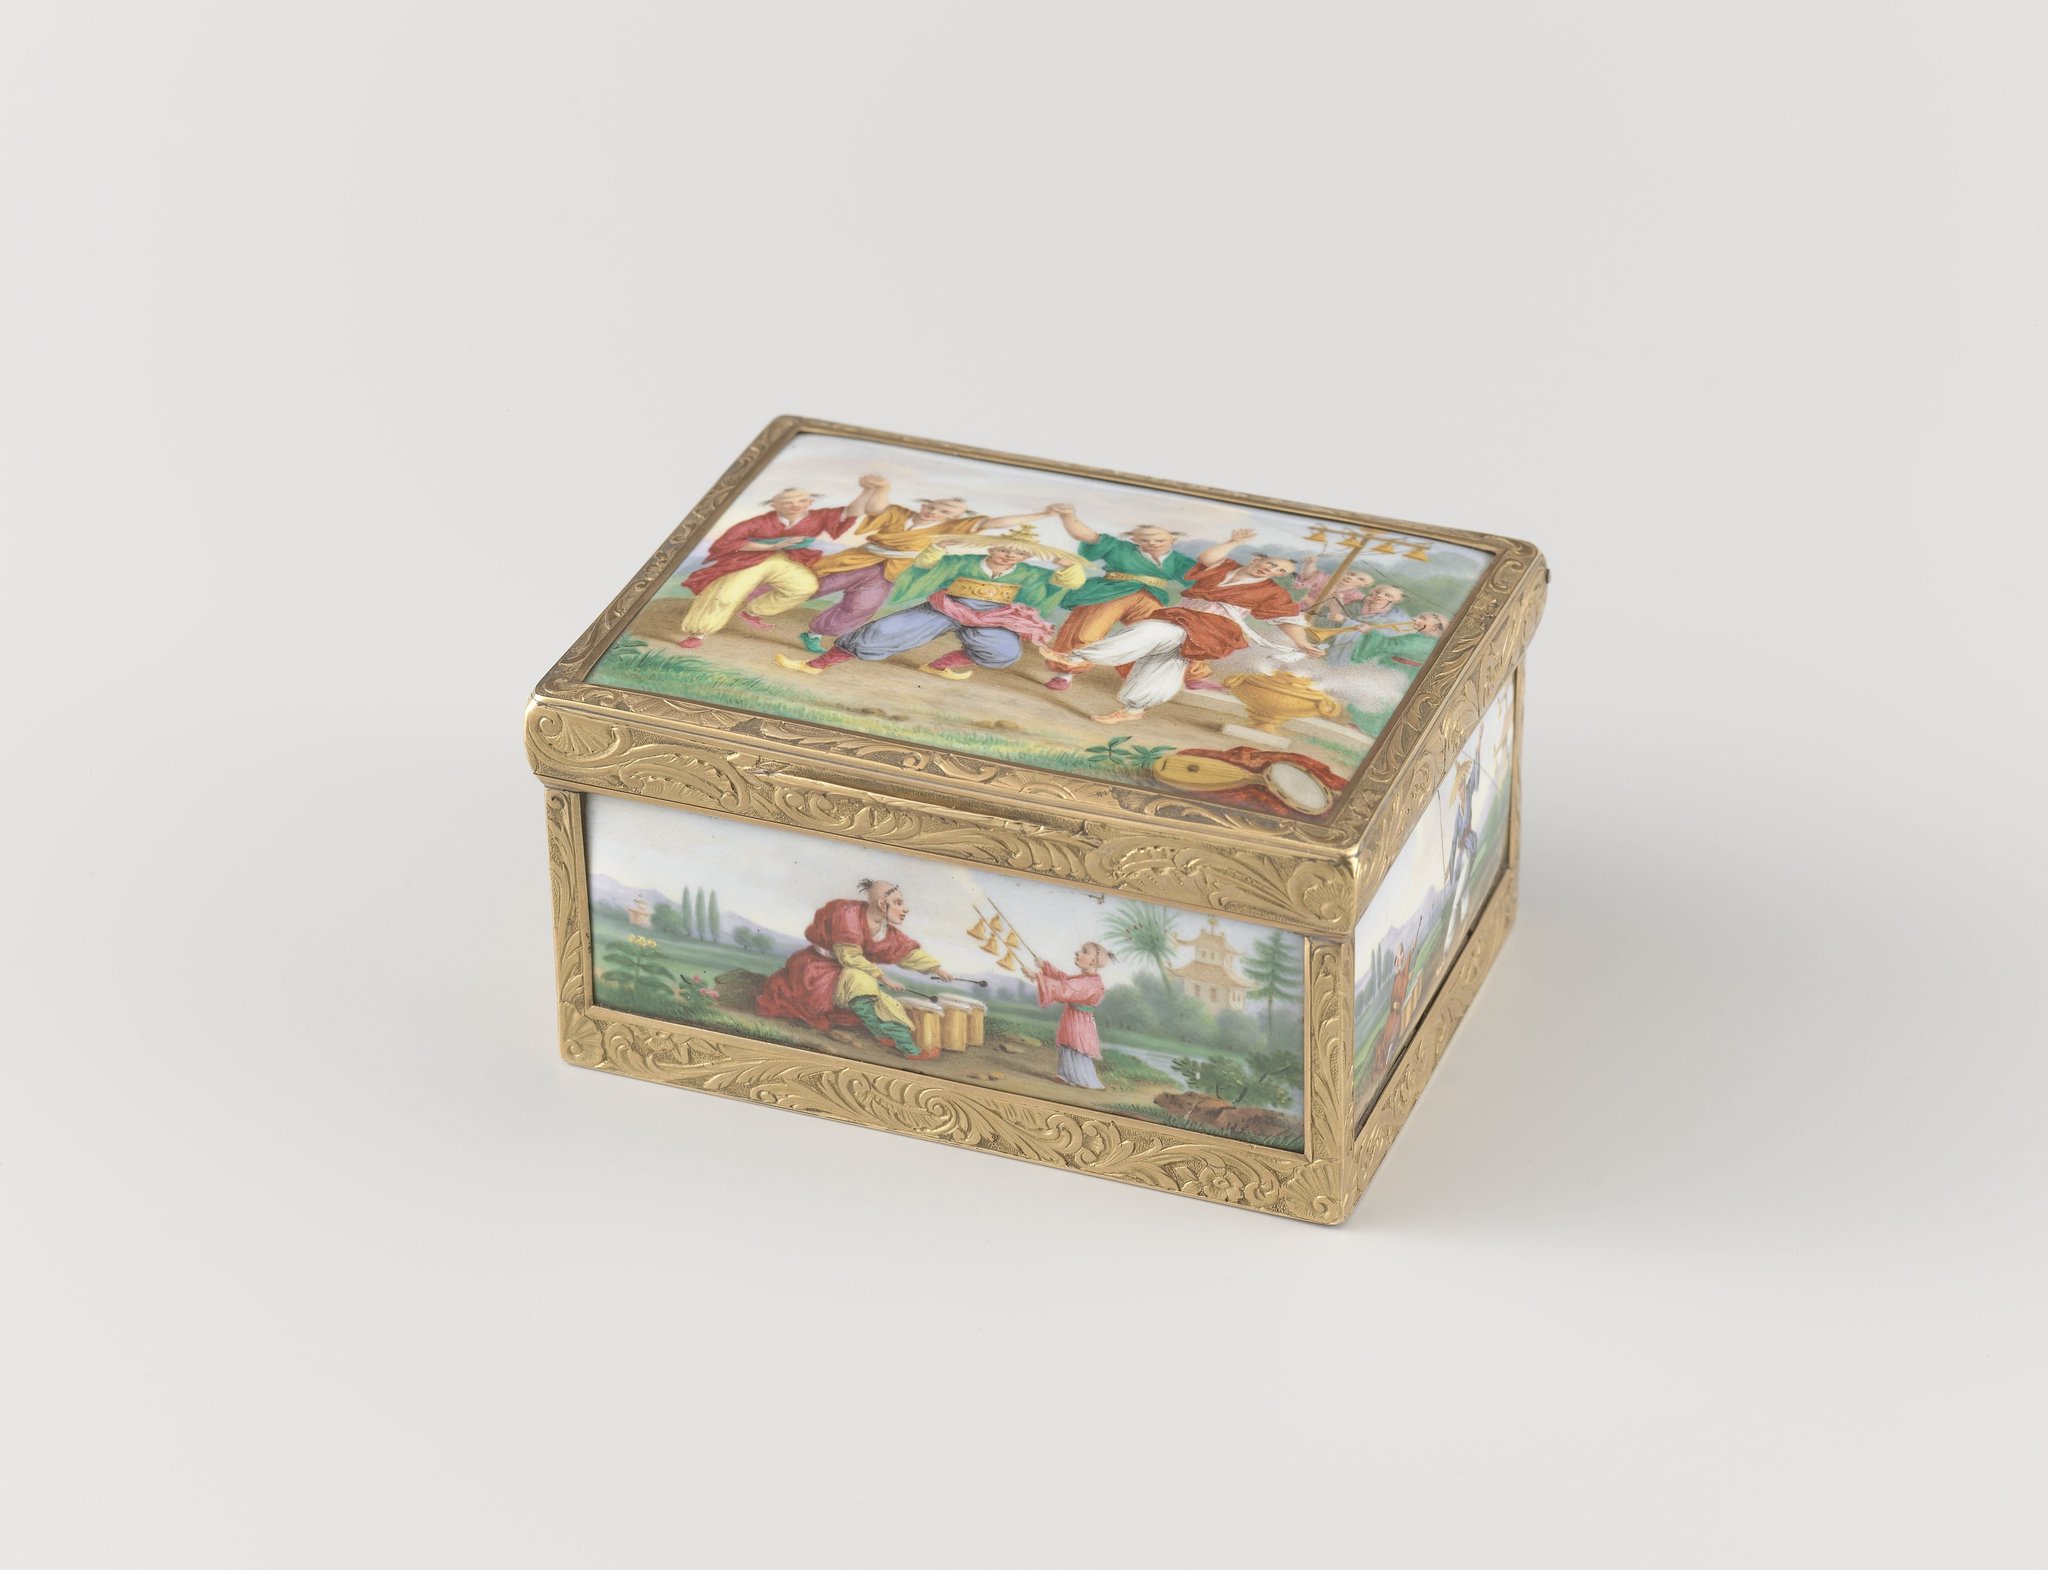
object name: snuffbox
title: Snuifdoos van goud, rechthoekig met gewelfd deksel. Geheel geëmailleerd en beschilderd met Chinoiserieën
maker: Anonymous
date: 1820-1840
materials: gold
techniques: painted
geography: paris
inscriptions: date letter (false), countermark (false), maker's mark (false), duty mark (false)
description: Snuffbox. Gold and enamel. Paris, 1753 - 1754, by Noël Hardivilliers. Snuffbox. Gold and enamel Paris, 1767 - 1768.